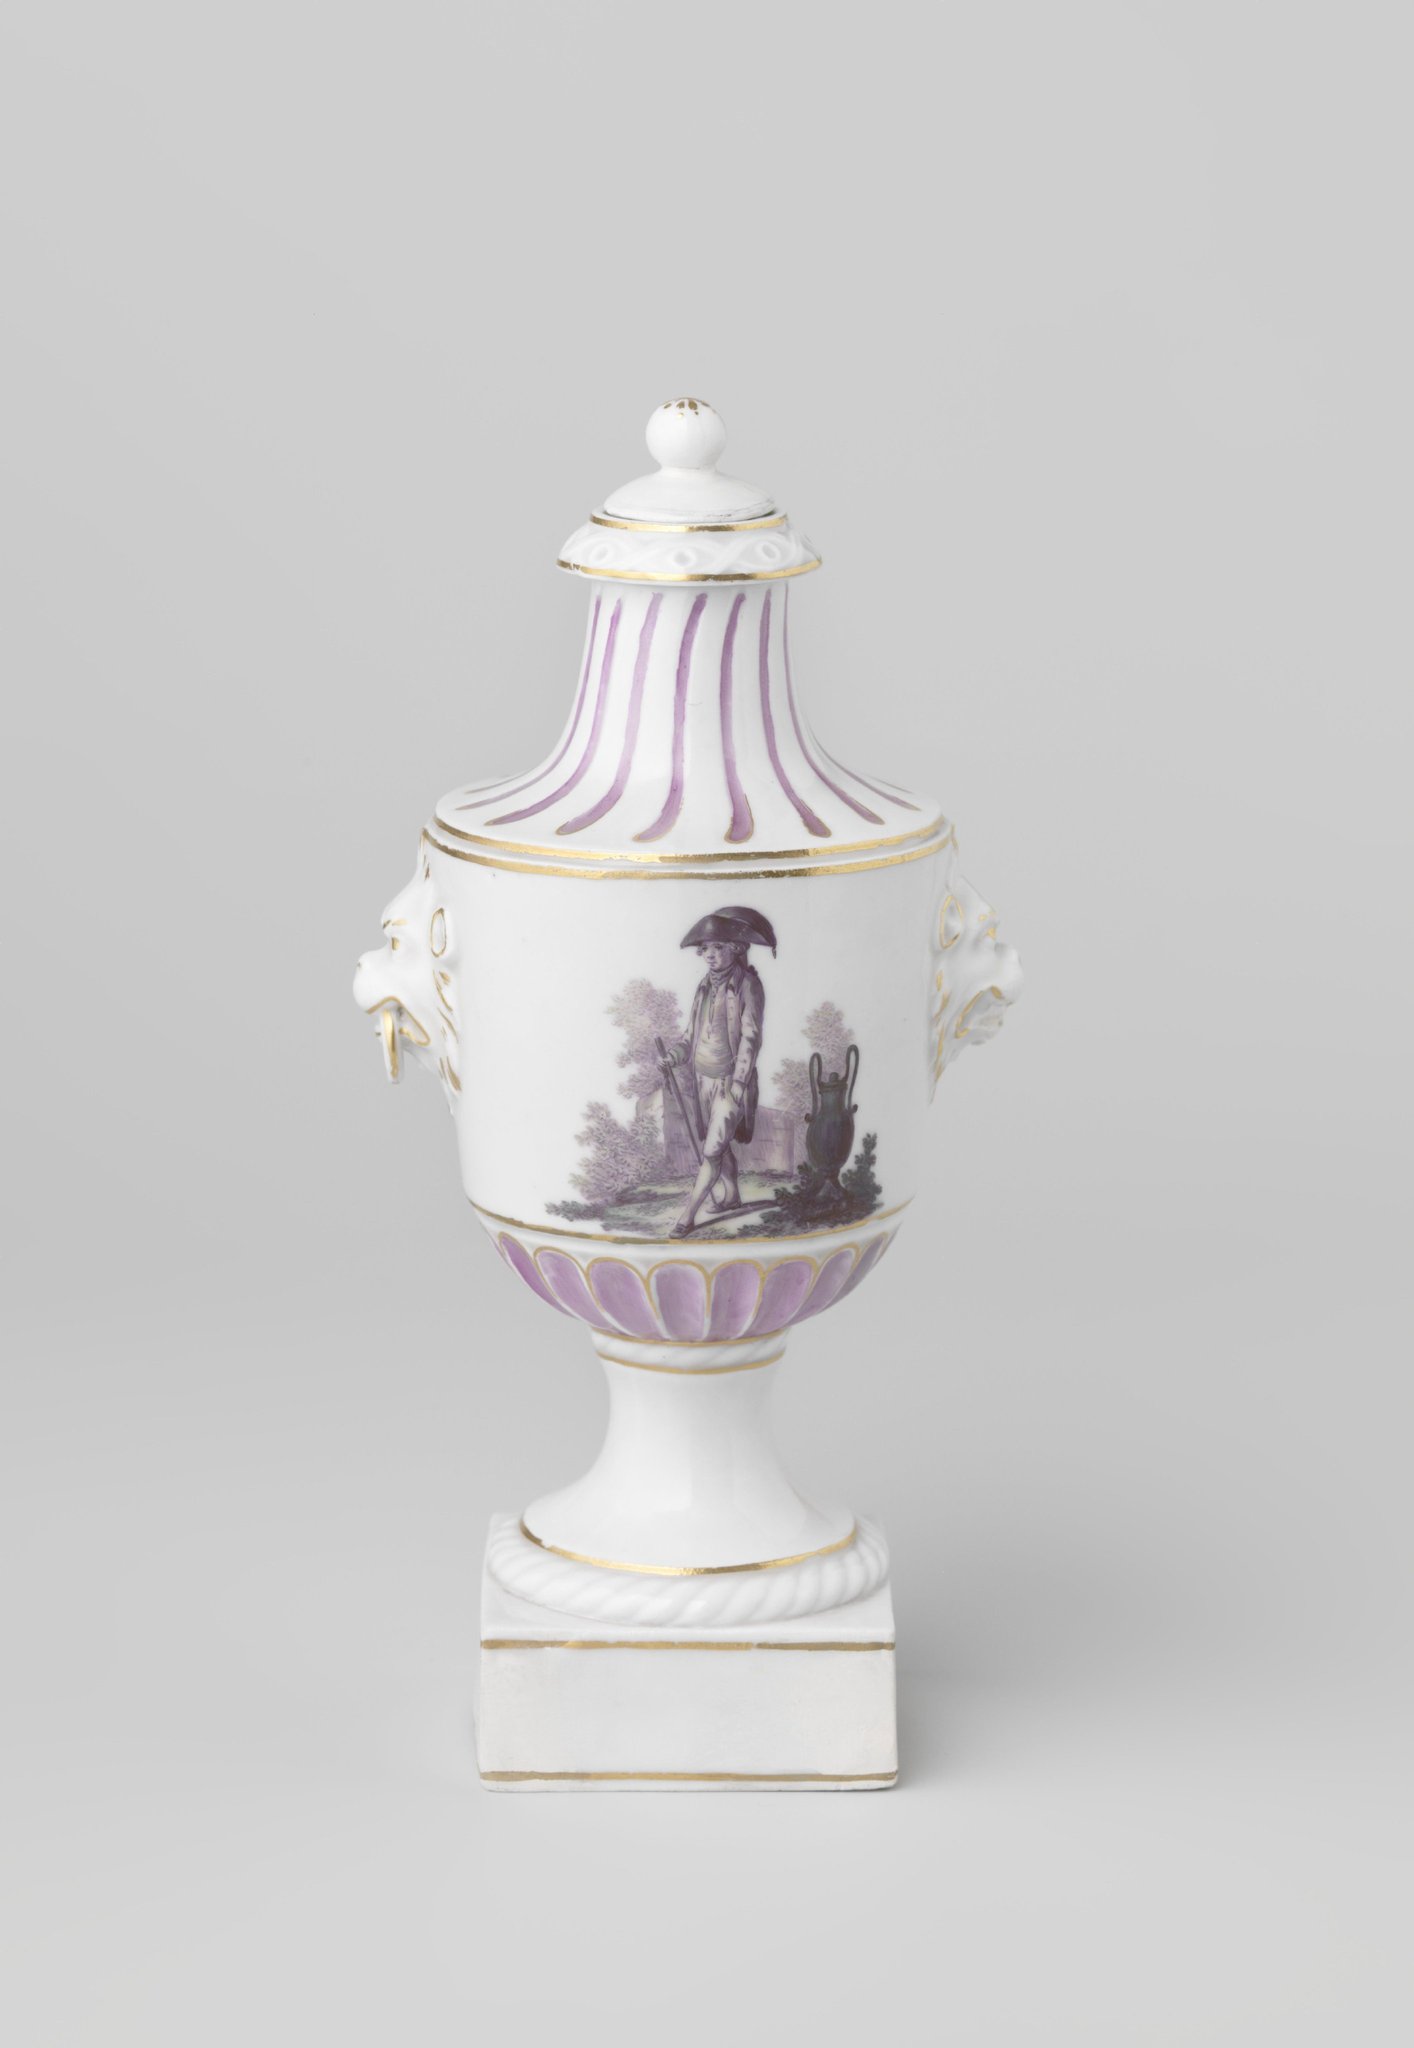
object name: vase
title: Vaas beschilderd met portret van Ds. Mol ten voeten uit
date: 1774-1784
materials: porcelain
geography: loosdrecht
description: Three vases and covers. Porcelain. Loosdrecht, c. 1778 - 1782. Factory of Joannes de Mol.